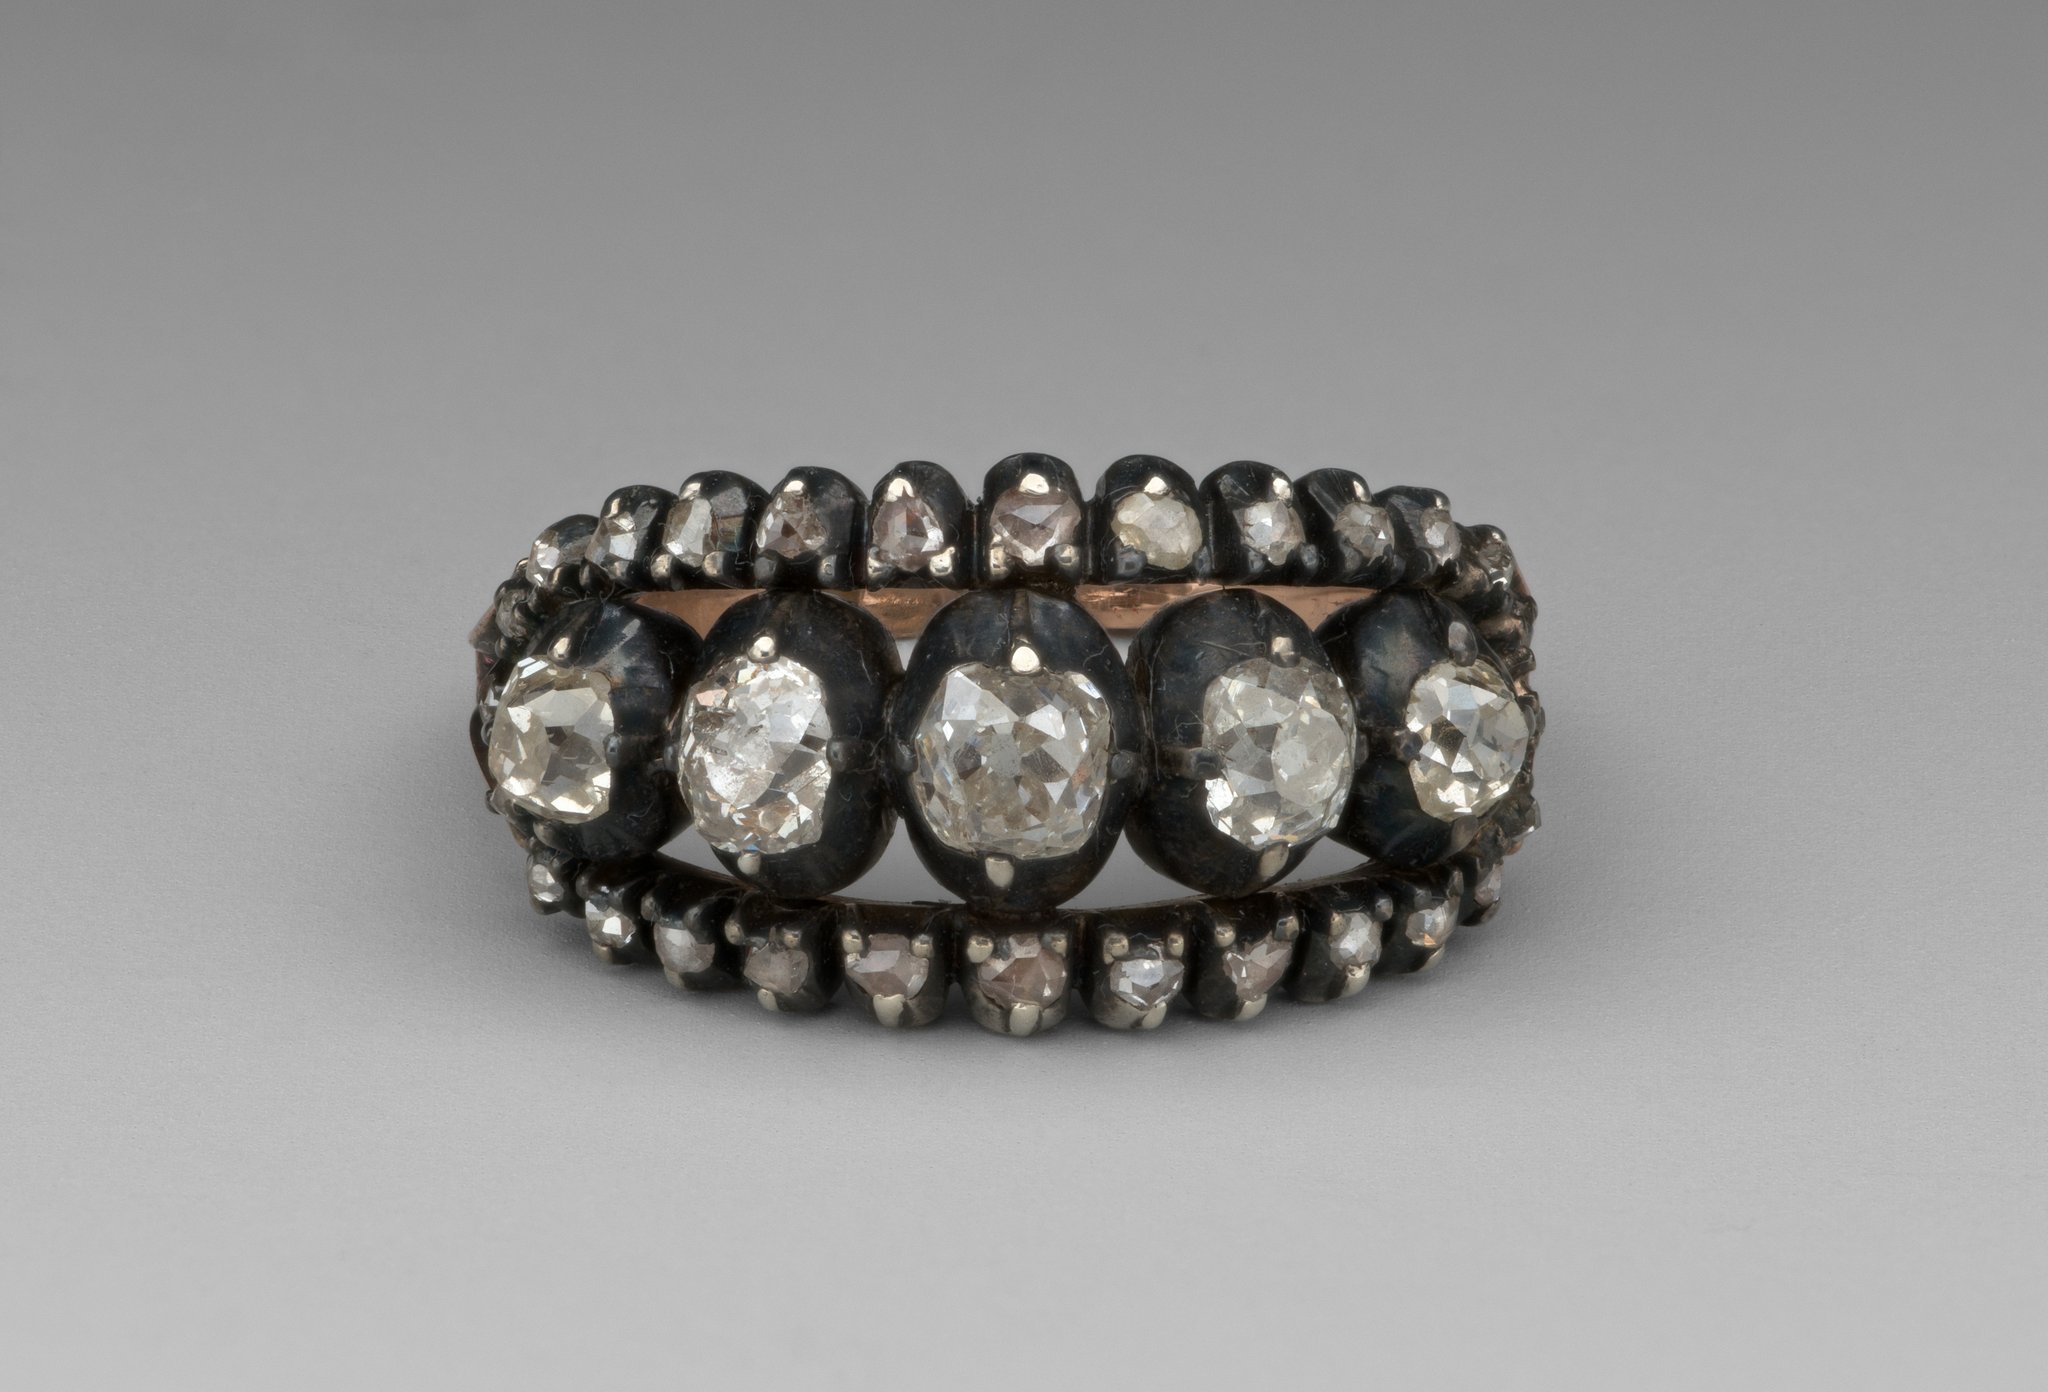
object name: ring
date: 1851-1900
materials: diamond, gold, silver